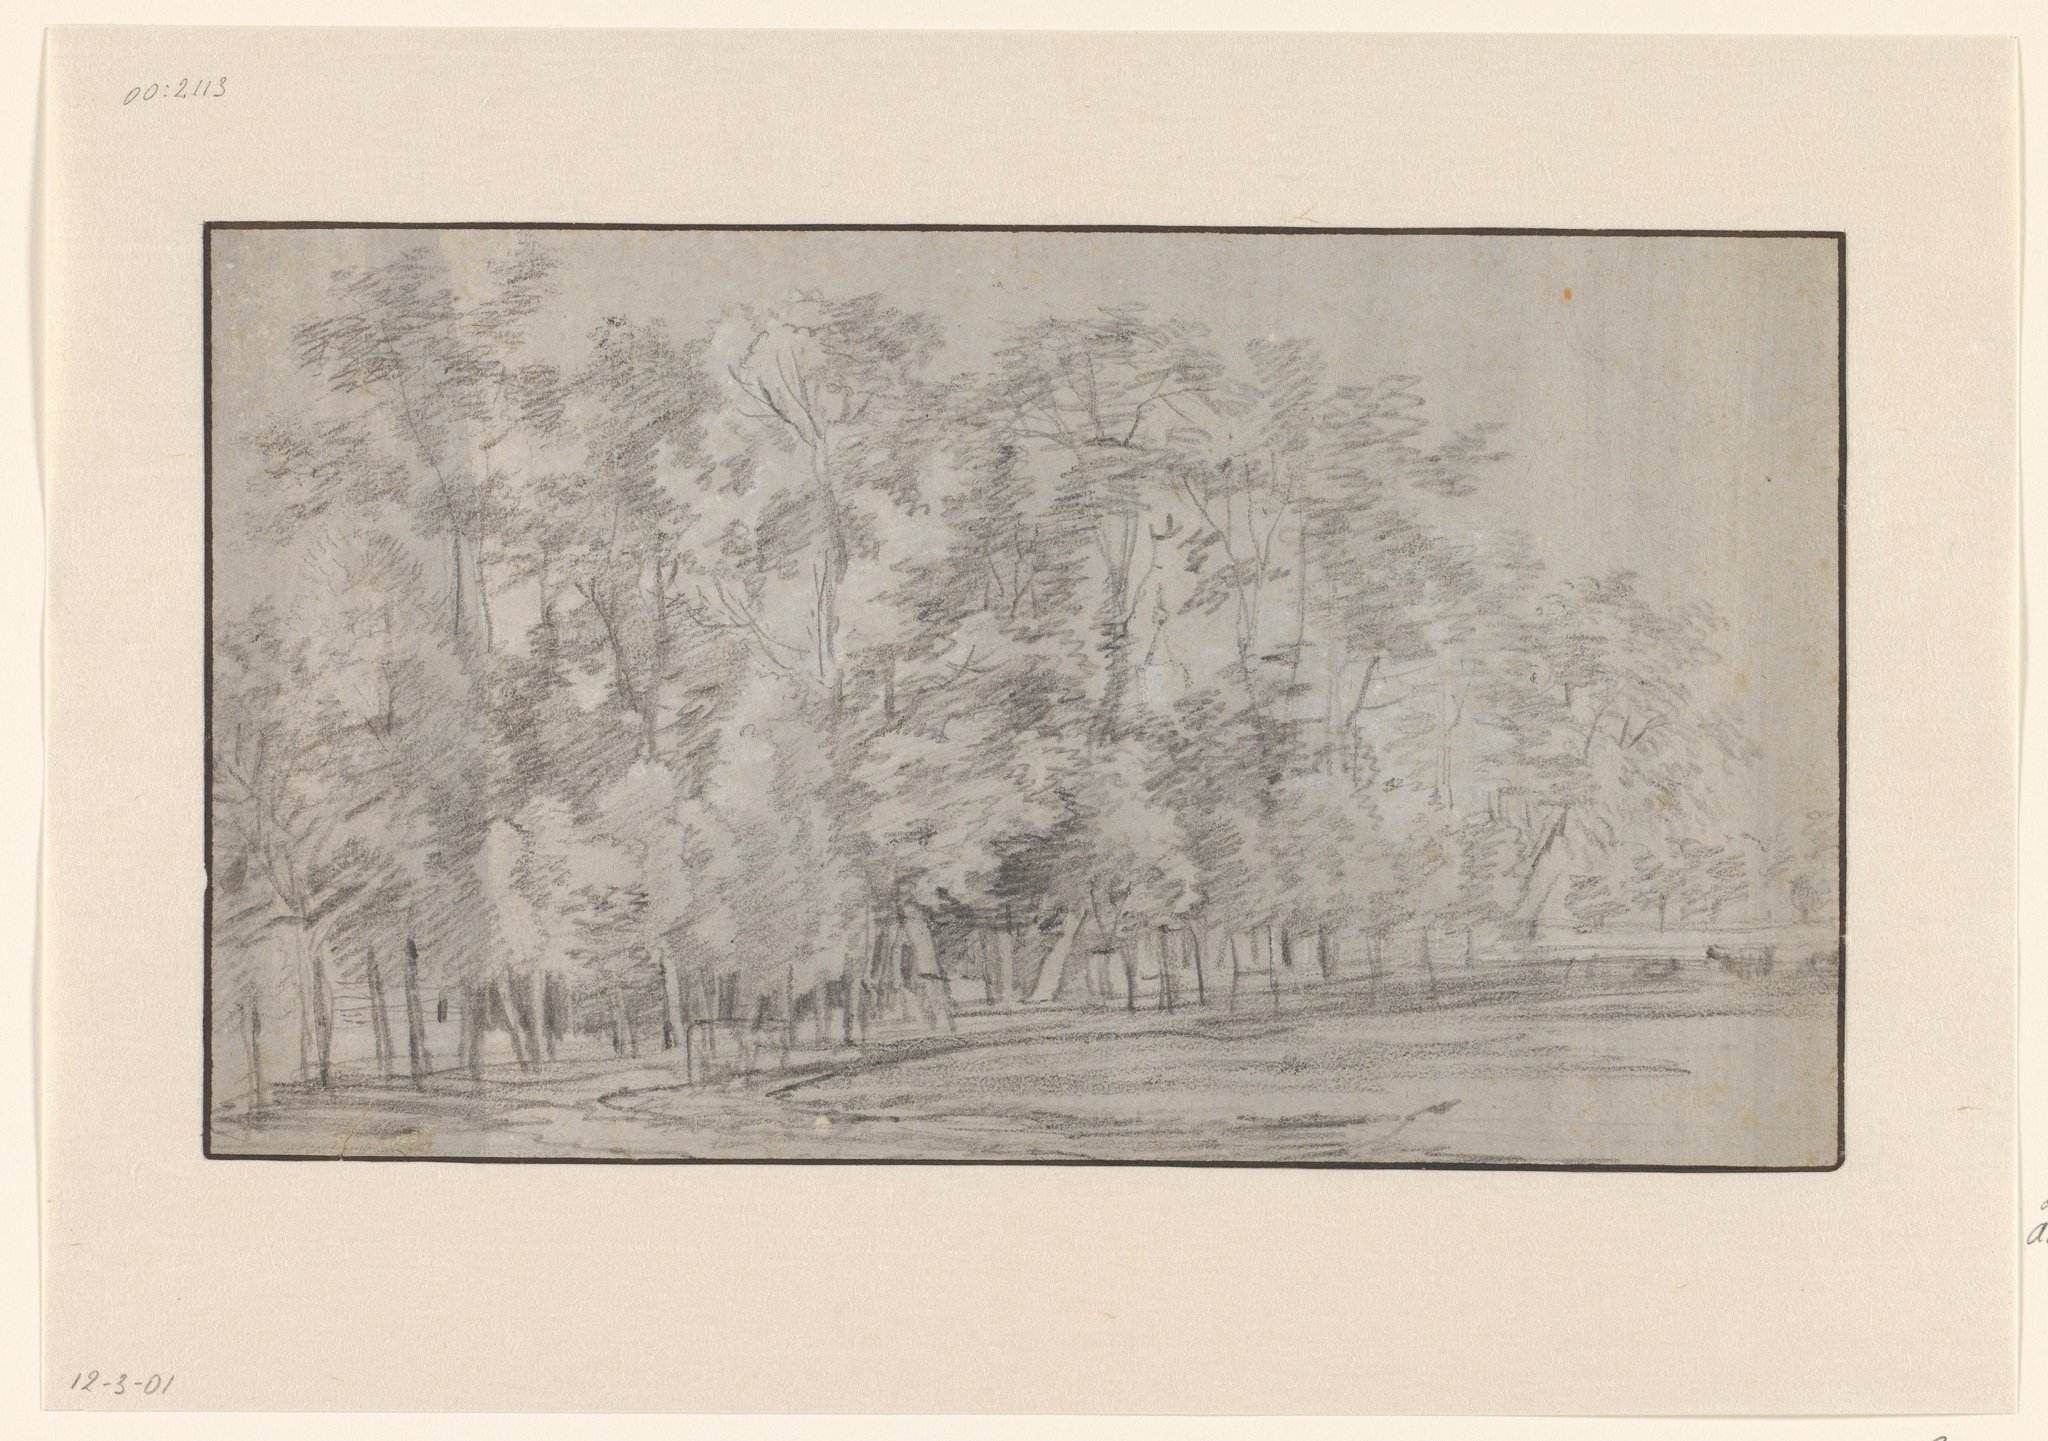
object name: drawing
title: Boslandschap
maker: Anonymous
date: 1800-1900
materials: chalk, paper